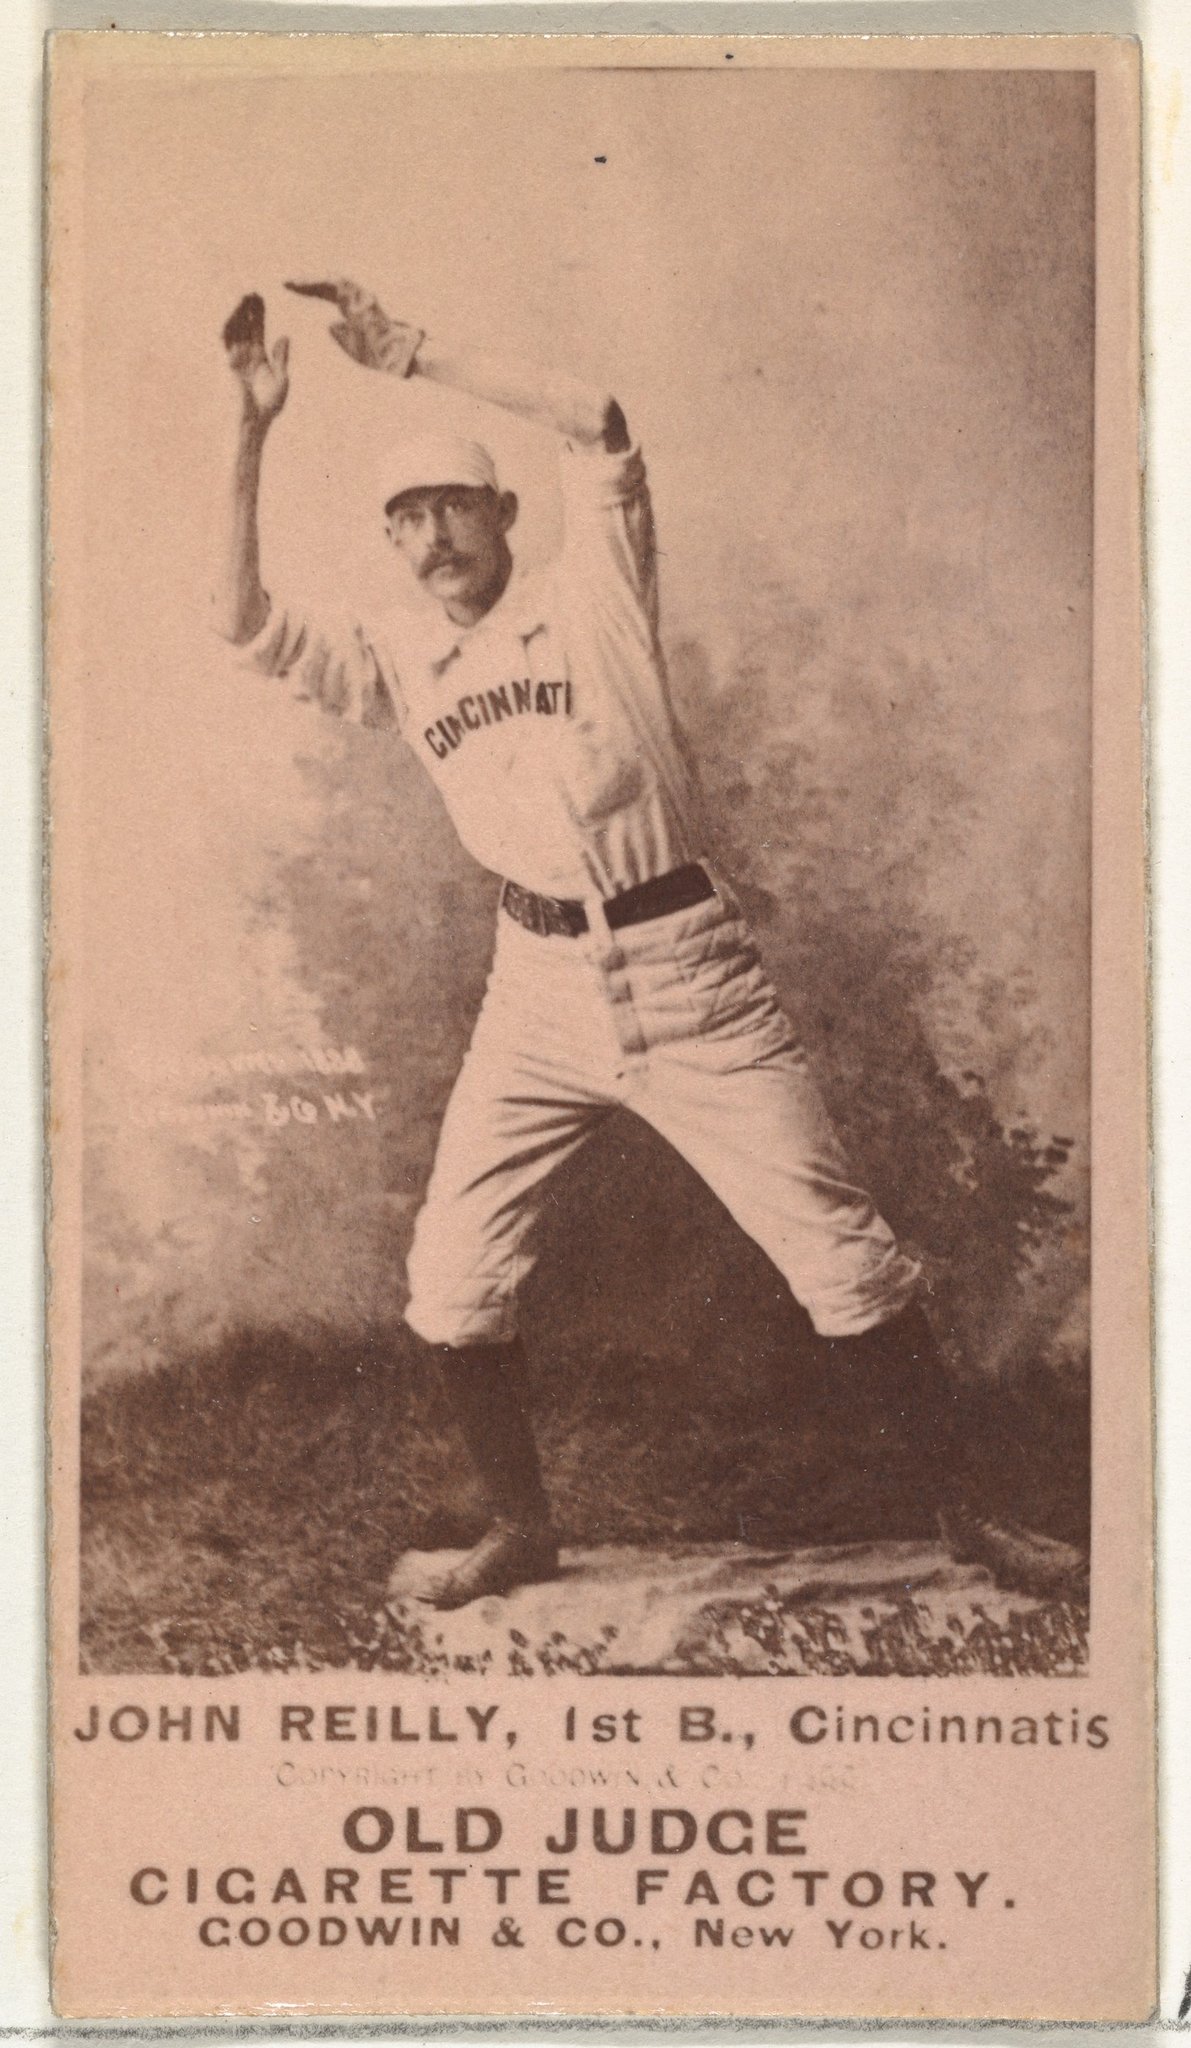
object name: baseball card, photograph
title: John Good "Long John" Reilly, 1st Base, Cincinnati, from the Old Judge series (N172) for Old Judge Cigarettes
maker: goodwin & company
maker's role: publisher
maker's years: 1850-1950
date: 1888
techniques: albumen silver print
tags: men,portraits,baseball,athletes